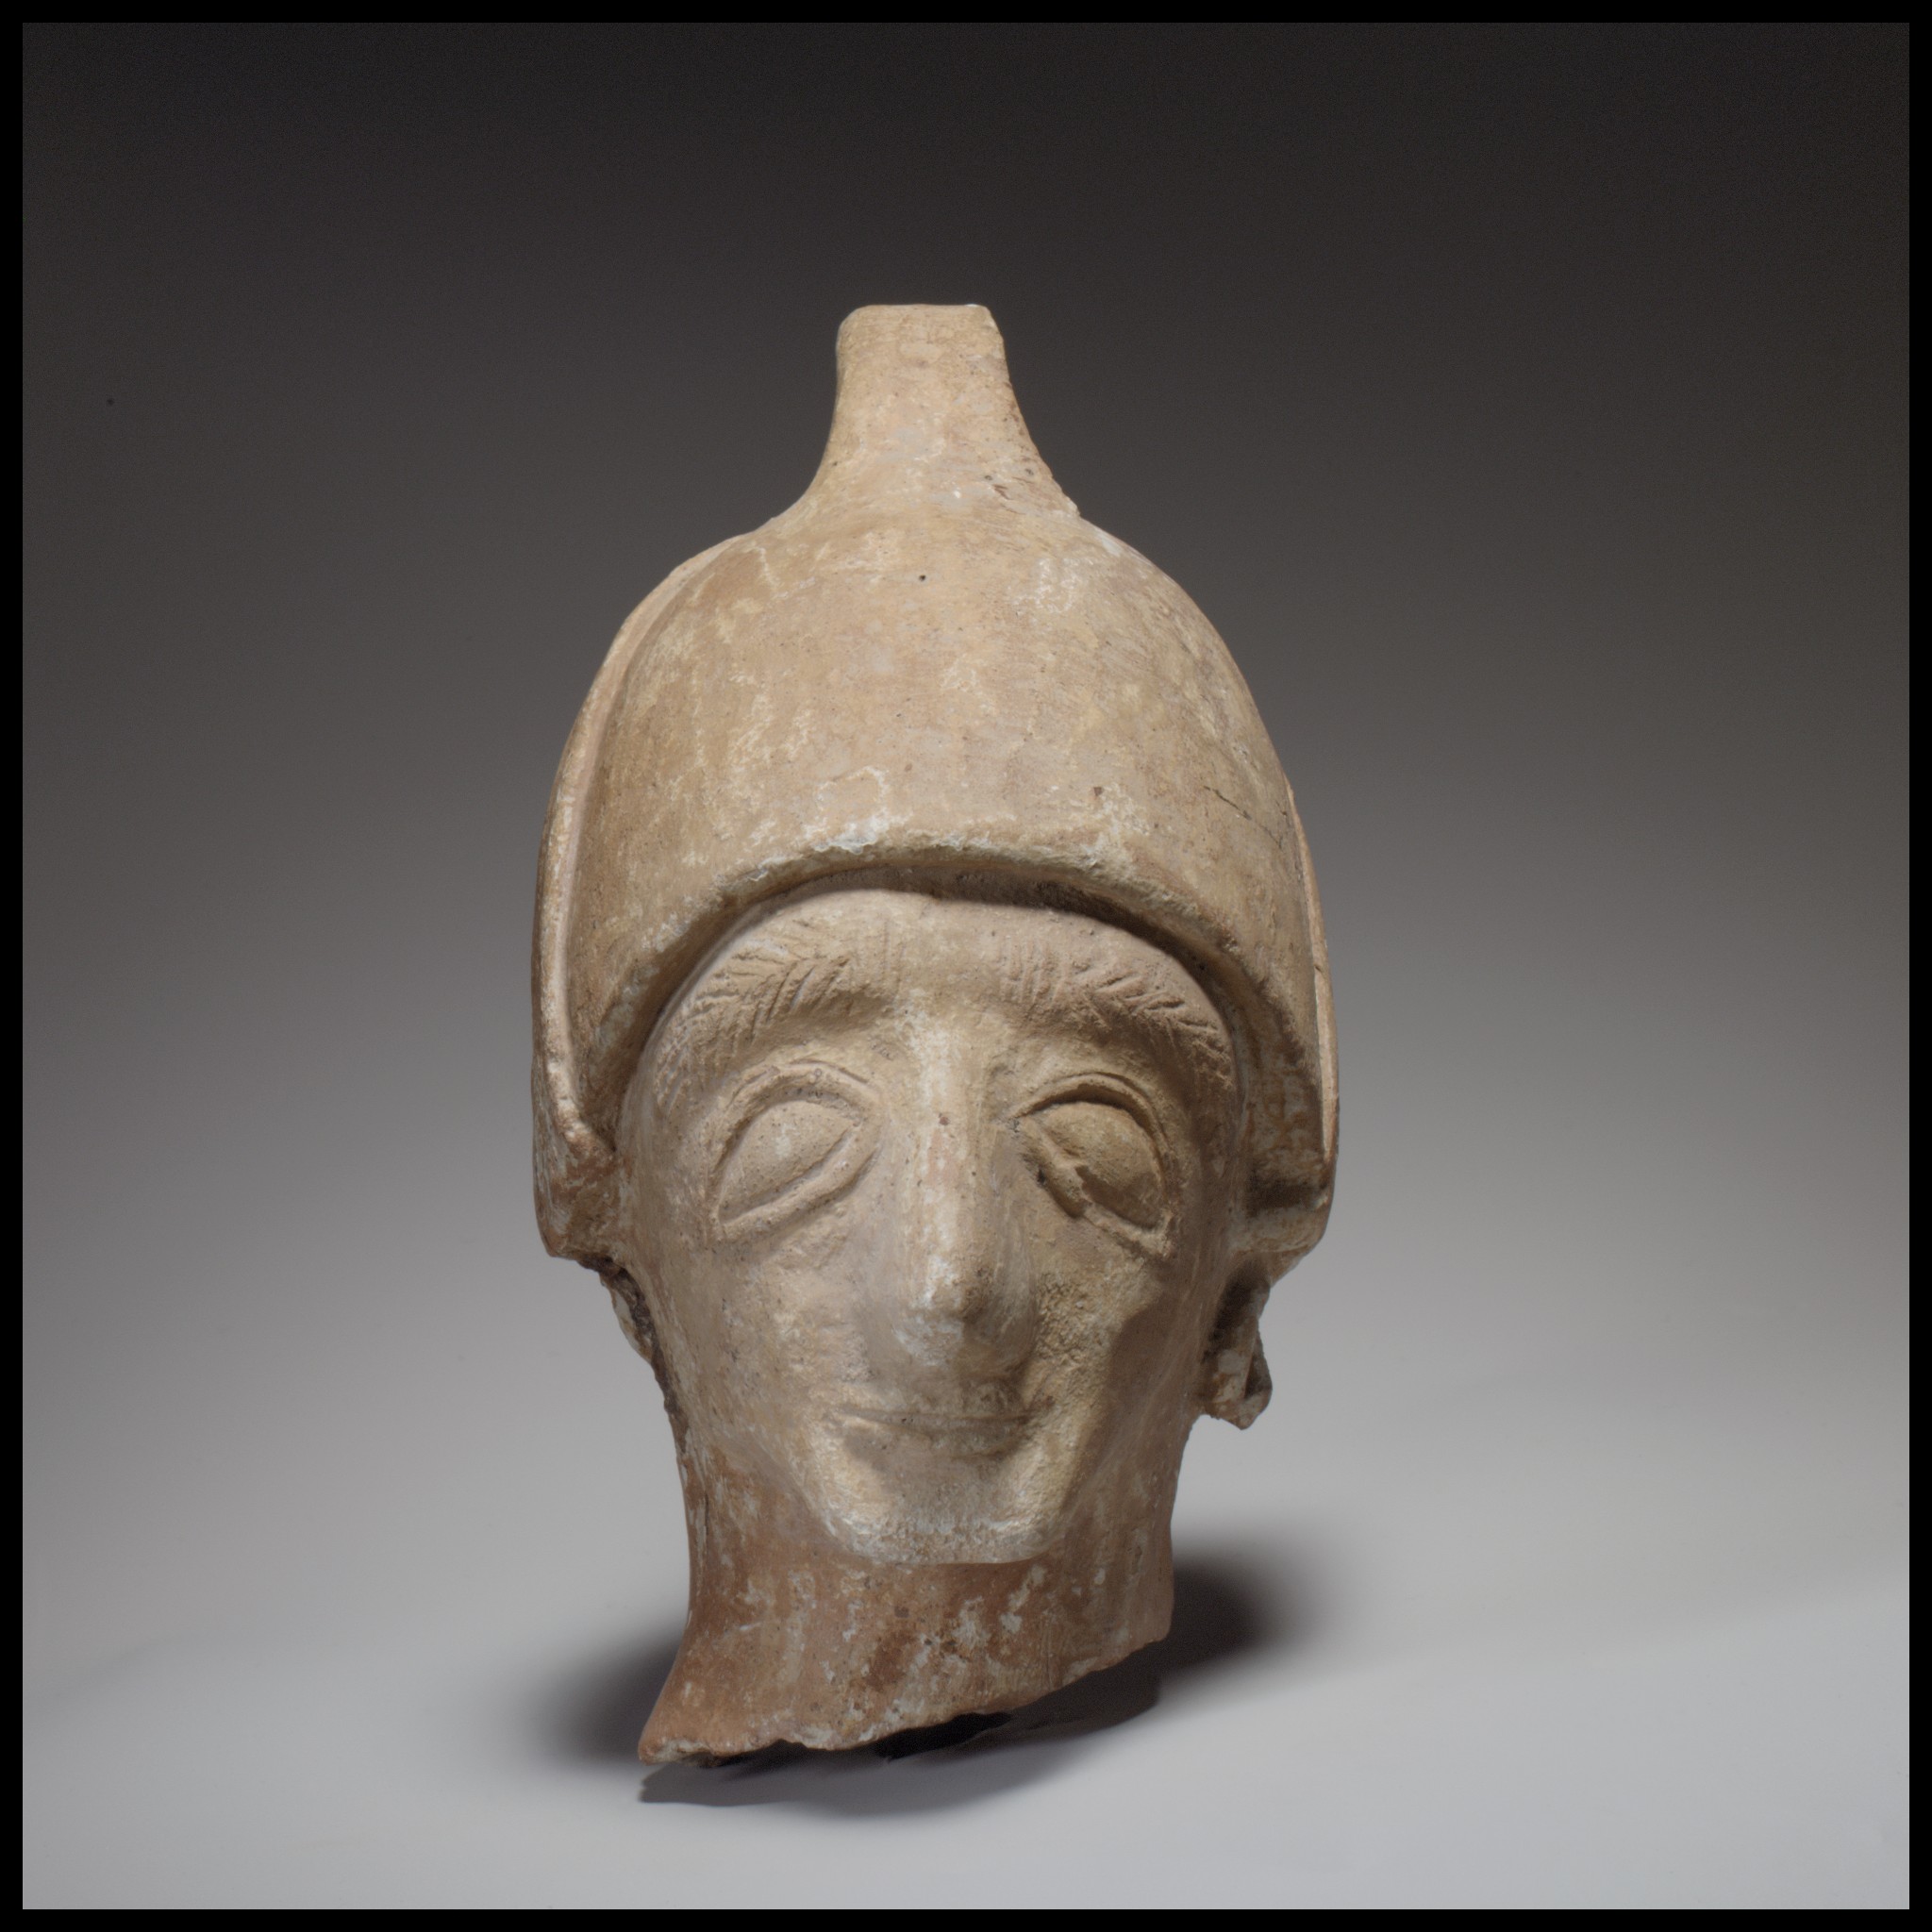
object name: head of a man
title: Male head wearing a helmet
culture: cypriot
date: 600-480 BCE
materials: terracotta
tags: helmets,heads,men